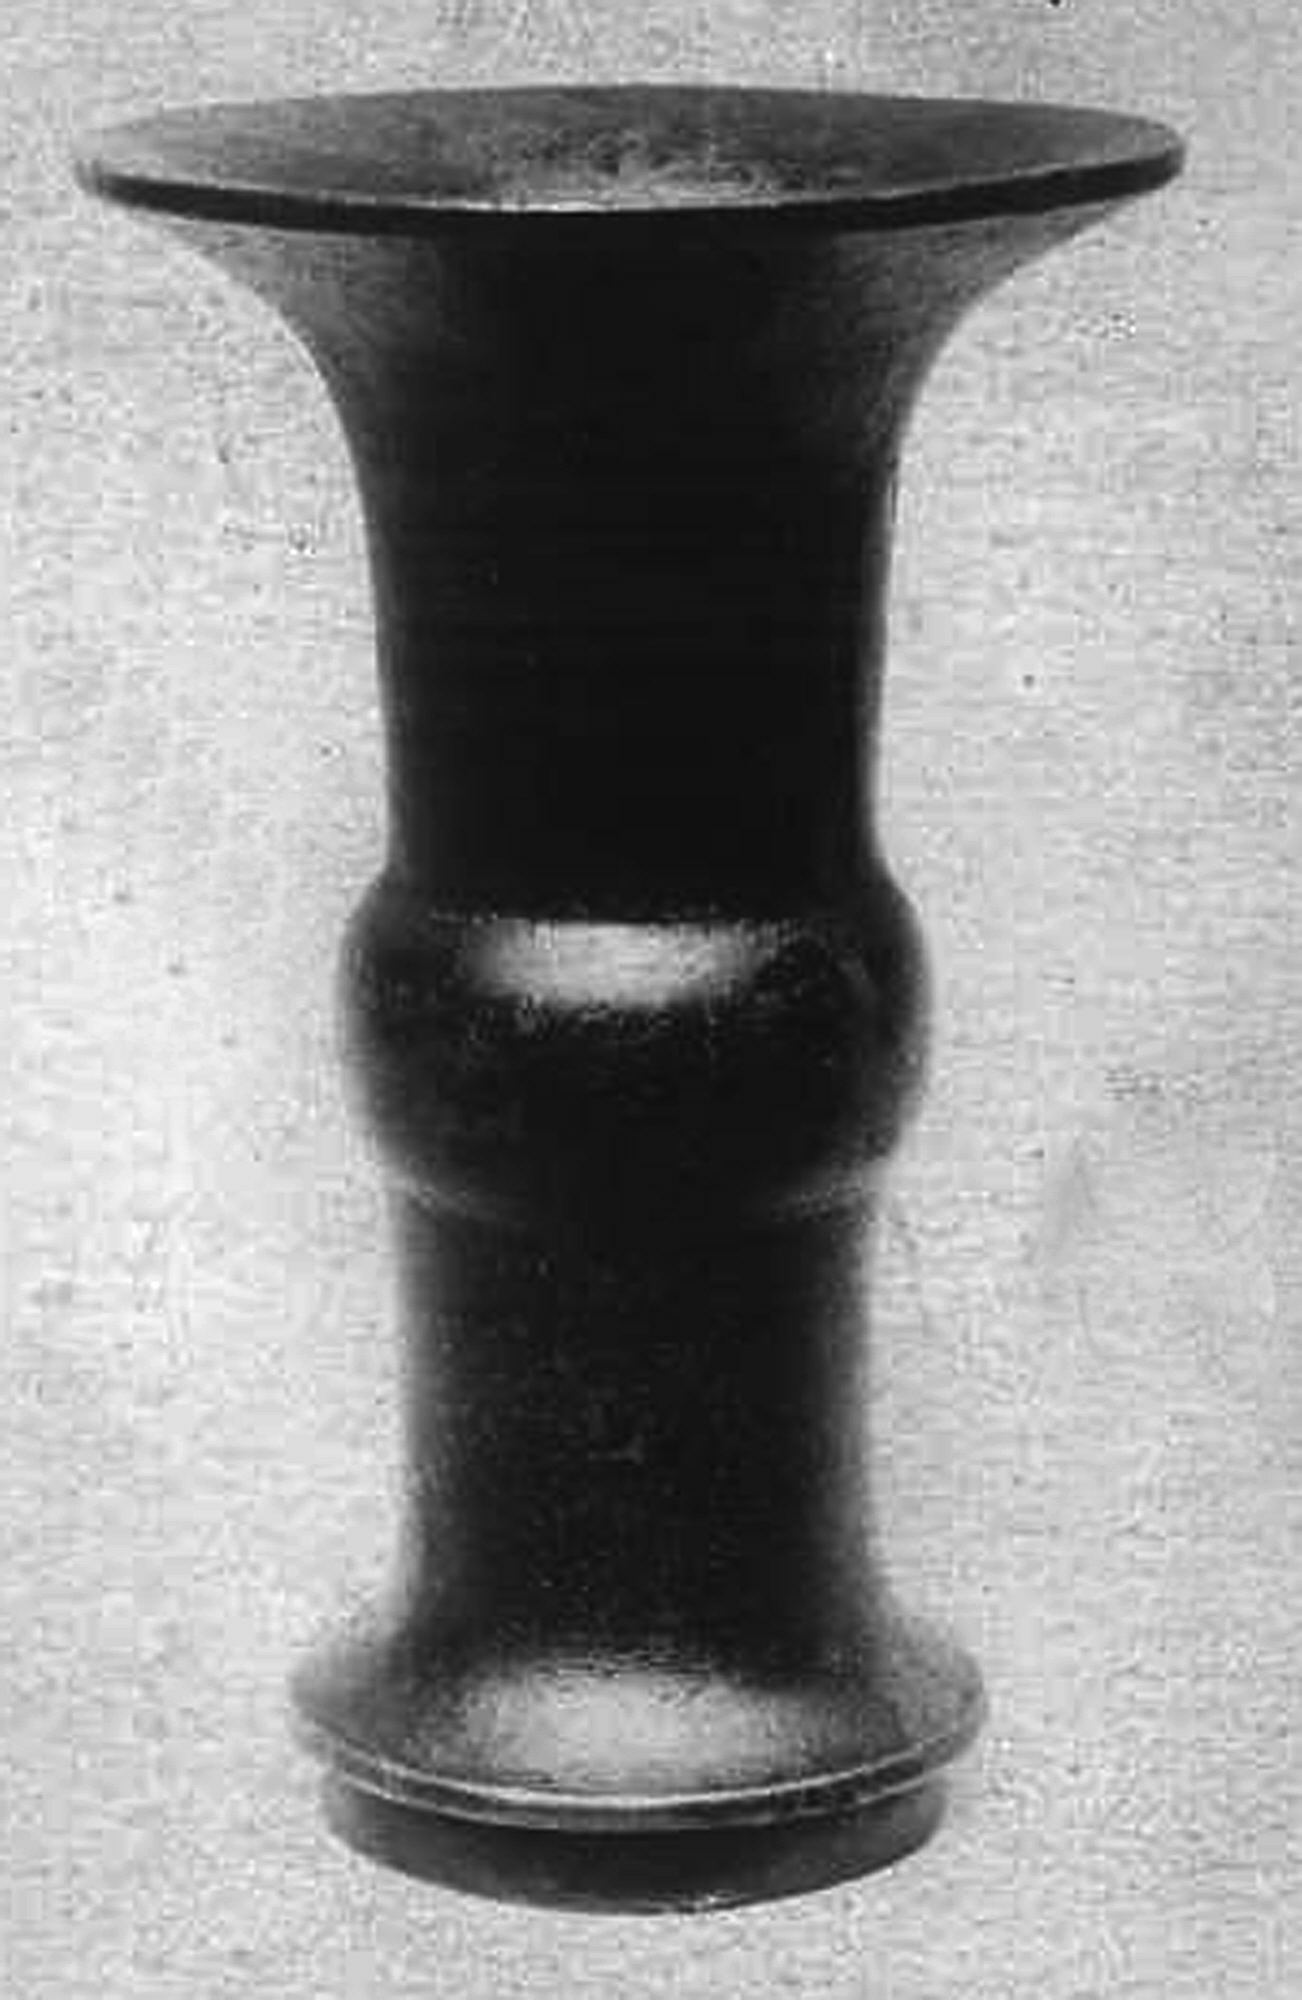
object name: vase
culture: japanese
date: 1734-1900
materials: bronze